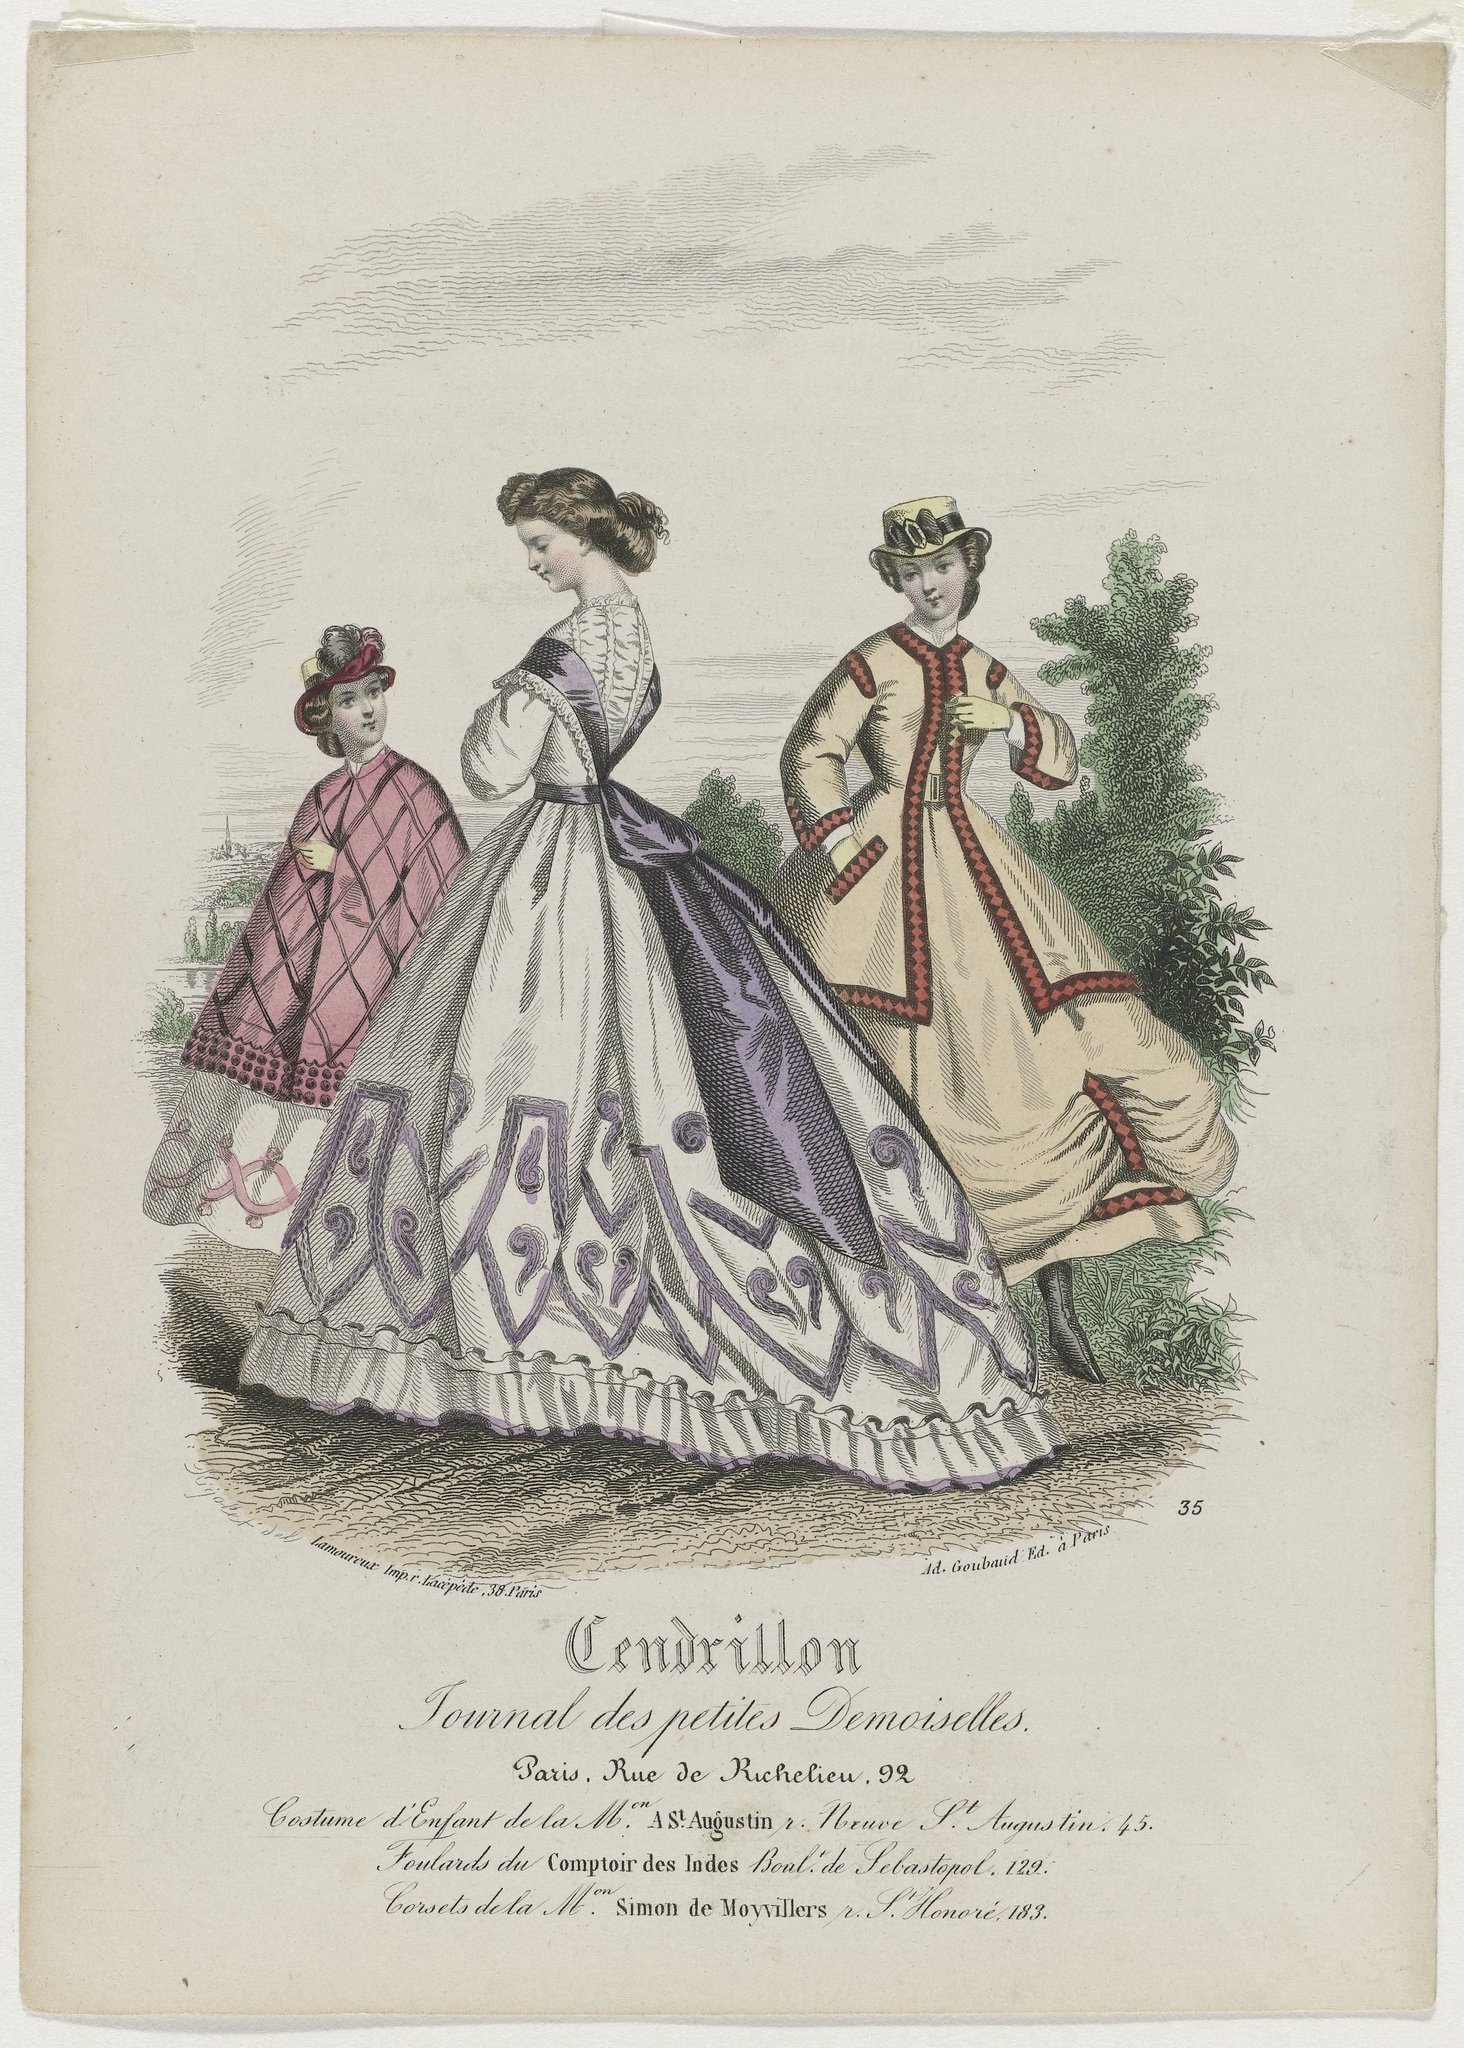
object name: fashion print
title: Cendrillon, 1866, No. 35 : Journal des petites Demoiselles...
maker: Anonymous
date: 1866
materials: paper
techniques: engraving, hand coloring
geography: paris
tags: skirt (+ girls' clothes), head-gear (+ girls' clothes), boots (+ girls' clothes), coat (+ girls' clothes), head-gear (+ women's clothes), fashion plates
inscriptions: address: ‘Paris, Rue de Richelieu, 92.’, caption: ‘Costume d'Enfant de la M.on A St Augustin r. Neuve S.t Augustin. 45. Foulards du Comptoir des Indes Boul.t de Sebastopol.129. Corsets de la M.on Simon de Moyvillers r. S.t Honoré. 183.’, title: ‘Cendrillon / Journal des petites Demoiselles.’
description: Twee vrouwen en een meisje in de buitenlucht. Het meisje draagt kleding van maison St. Augustin. Onder de voorstelling enkele regeles reclametekst voor verschillende producten. Prent uit het modetijdschrift Cendrillon (1850-1872).